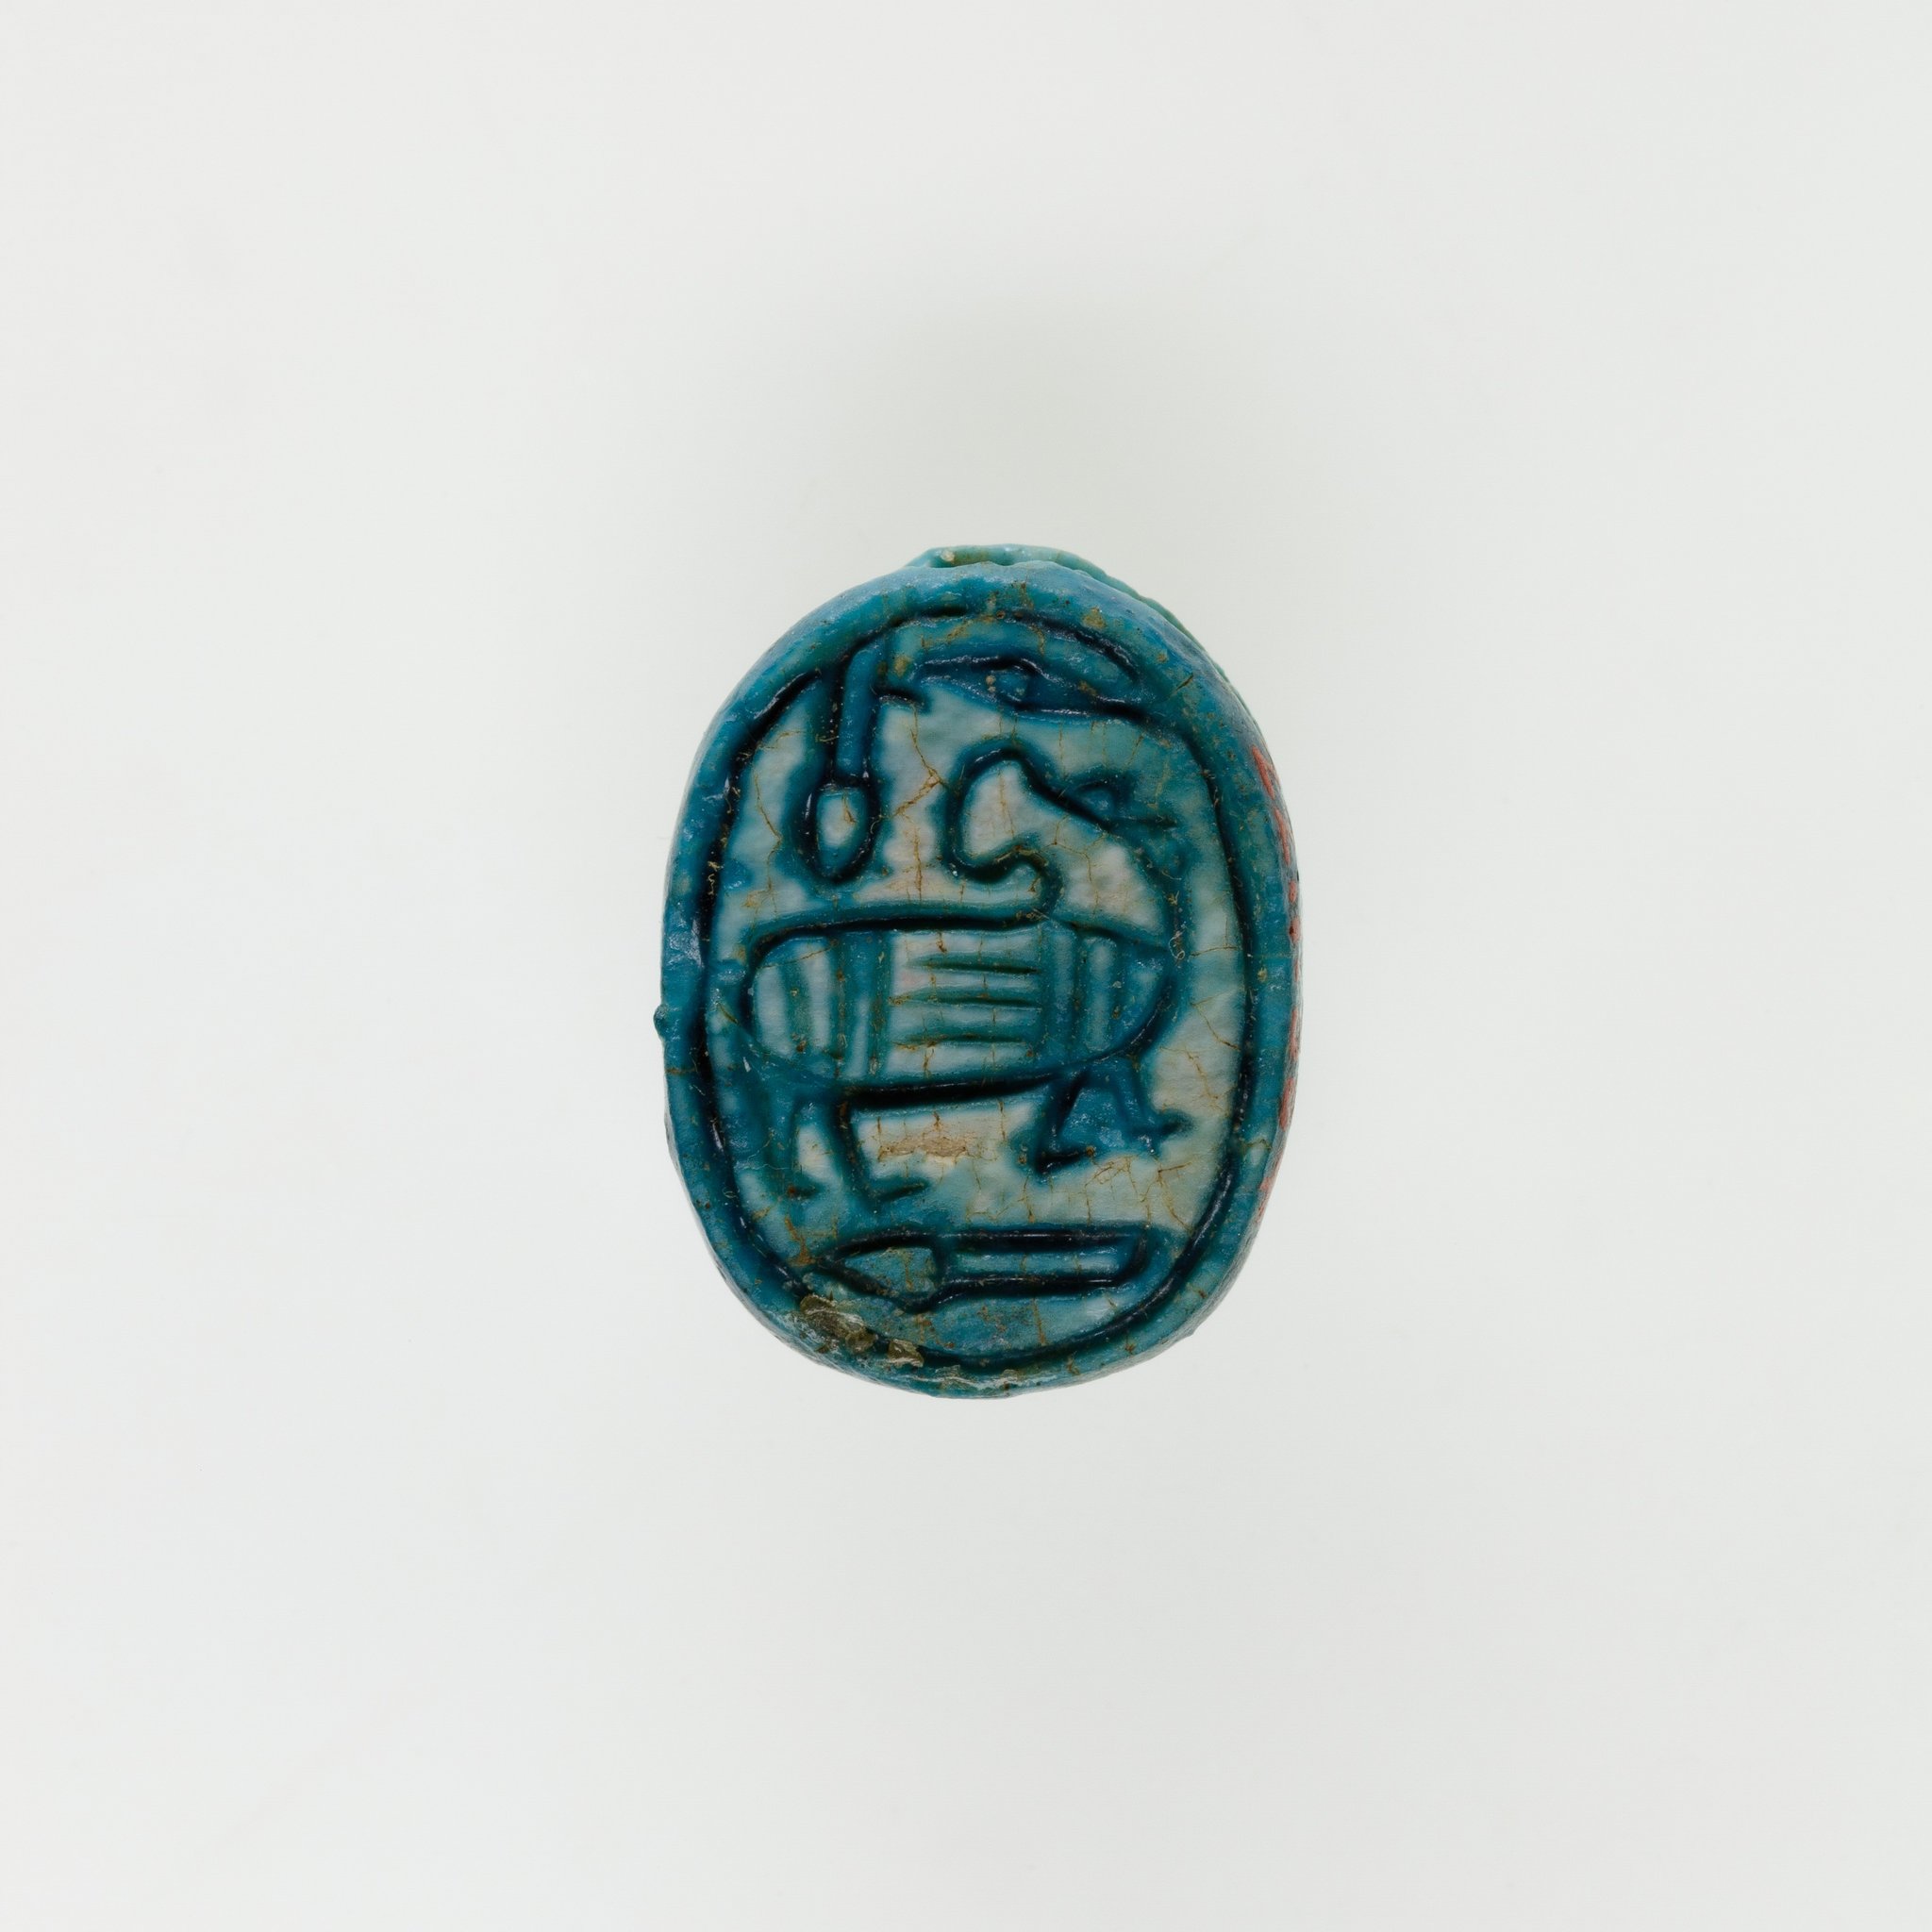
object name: scarab, hippo, nefer, hieroglyph, eye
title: Scarab with the Representation of a Hippo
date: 1740-1640 BCE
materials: stone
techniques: glazing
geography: egypt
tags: hippos,scarabs